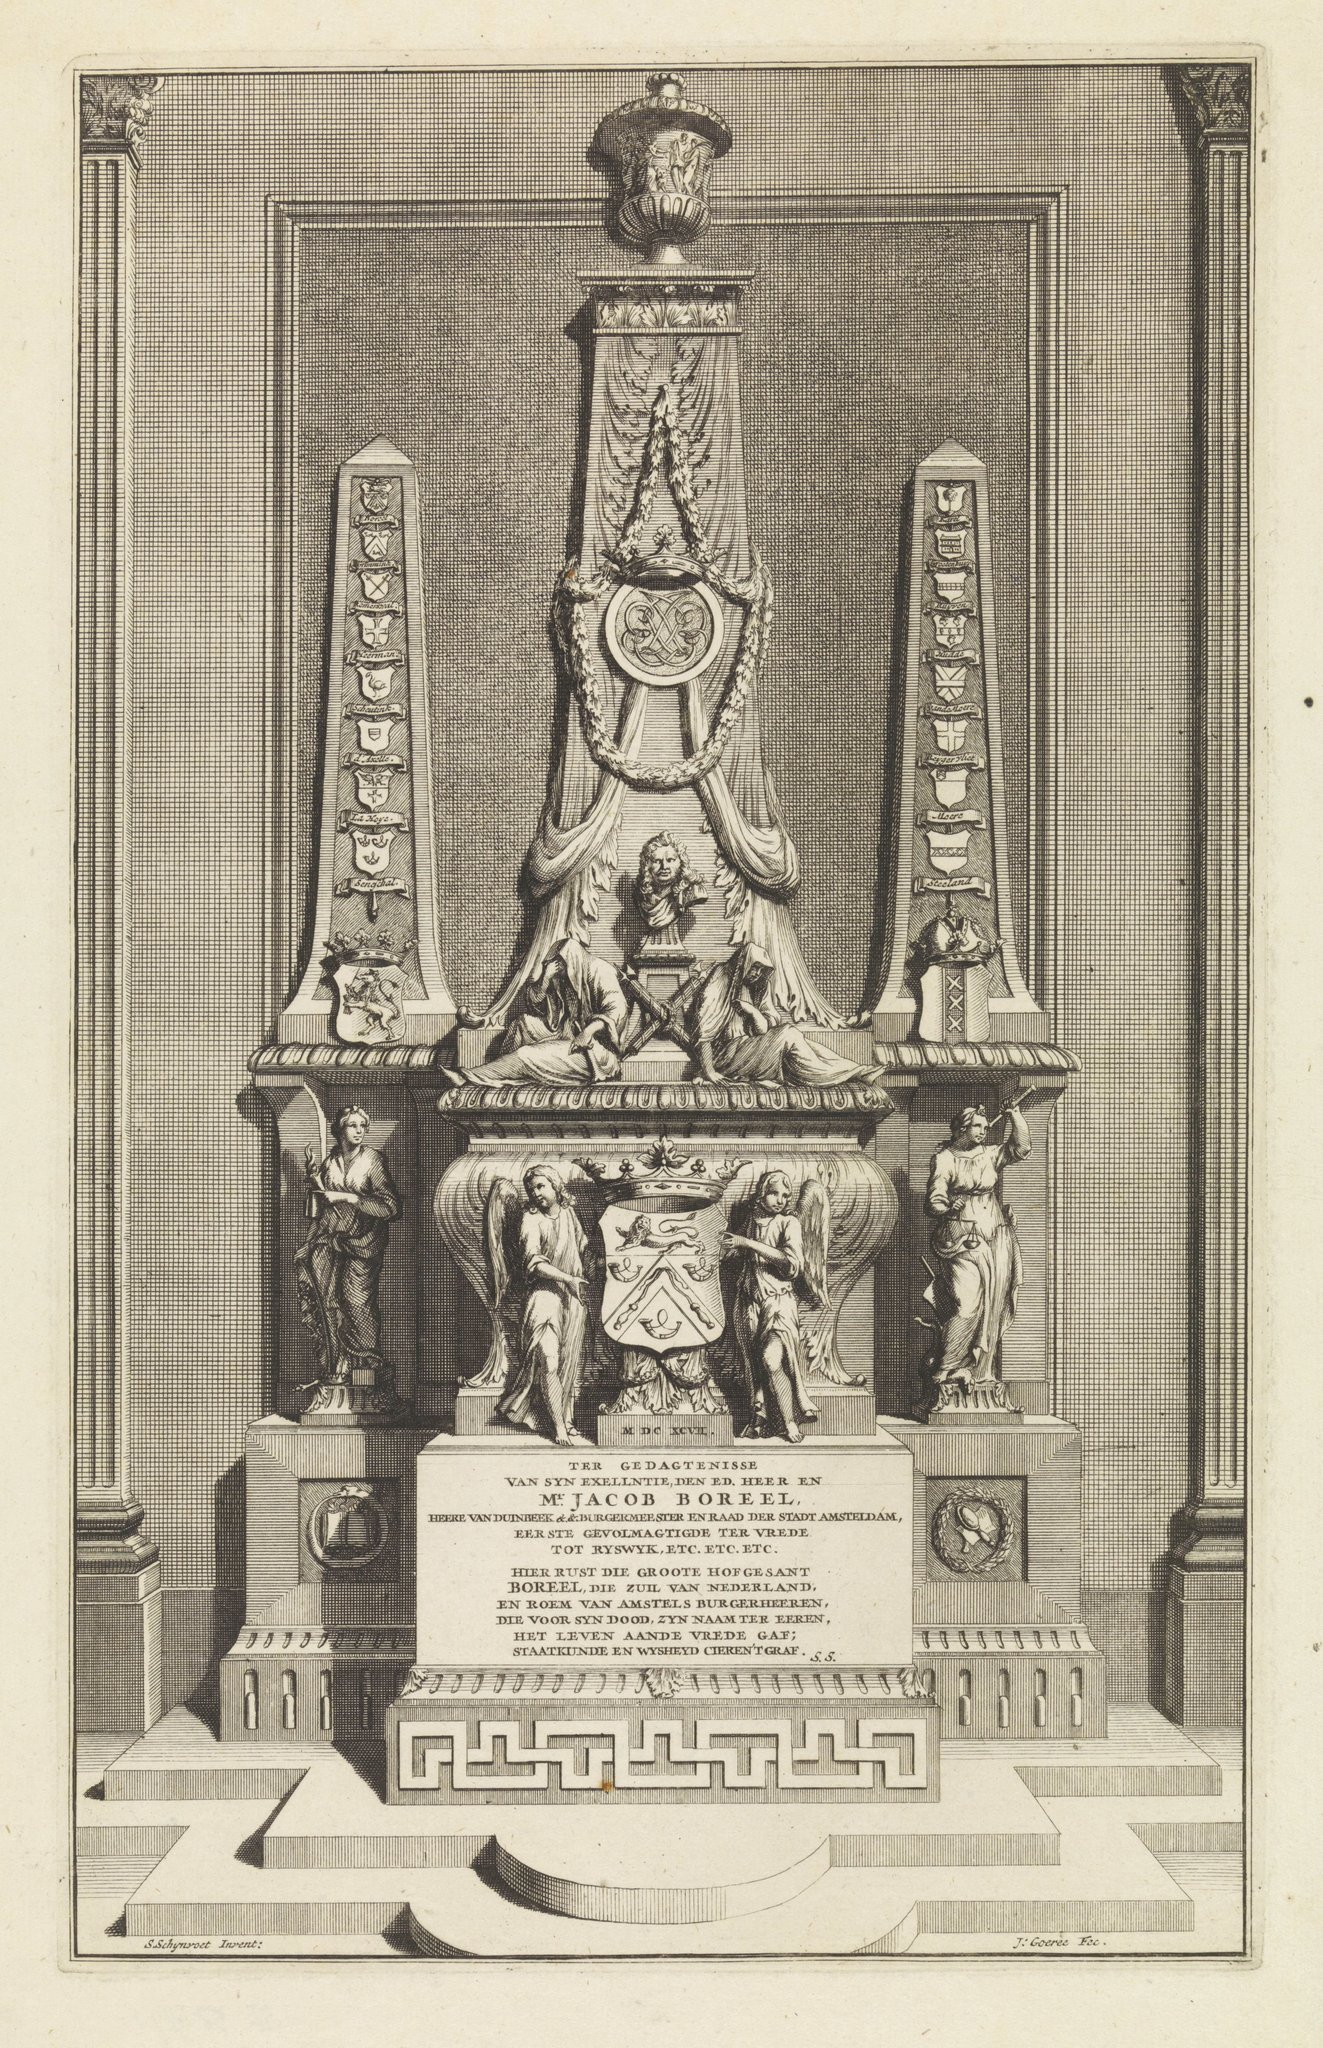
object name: print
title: Ter gedachtenisse van syn exellntie, den ed. heer en Mr. Jacob Boreel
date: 1697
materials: paper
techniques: engraving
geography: amsterdam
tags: mayor, obelisk, needle, 'pleurants', effigy, 'gisant' (portrait-figure on closed coffin or in 'castrum doloris'), transi, sarcophagus, grave-building, monumental tomb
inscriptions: collector's mark: Lugt 2228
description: Een grafmonument met op een voetstuk een sarcofaag. Boven de sarcofaag tussen twee pleurants een gebeeldhouwde buste van de overledene: Jacob Boreel. Aan weerszijden van de sarcofaag een obelisk met wapenschilden van zijn aanverwanten. Op het voetstuk het wapenschild van Boreel boven een Nederlands opschrift.